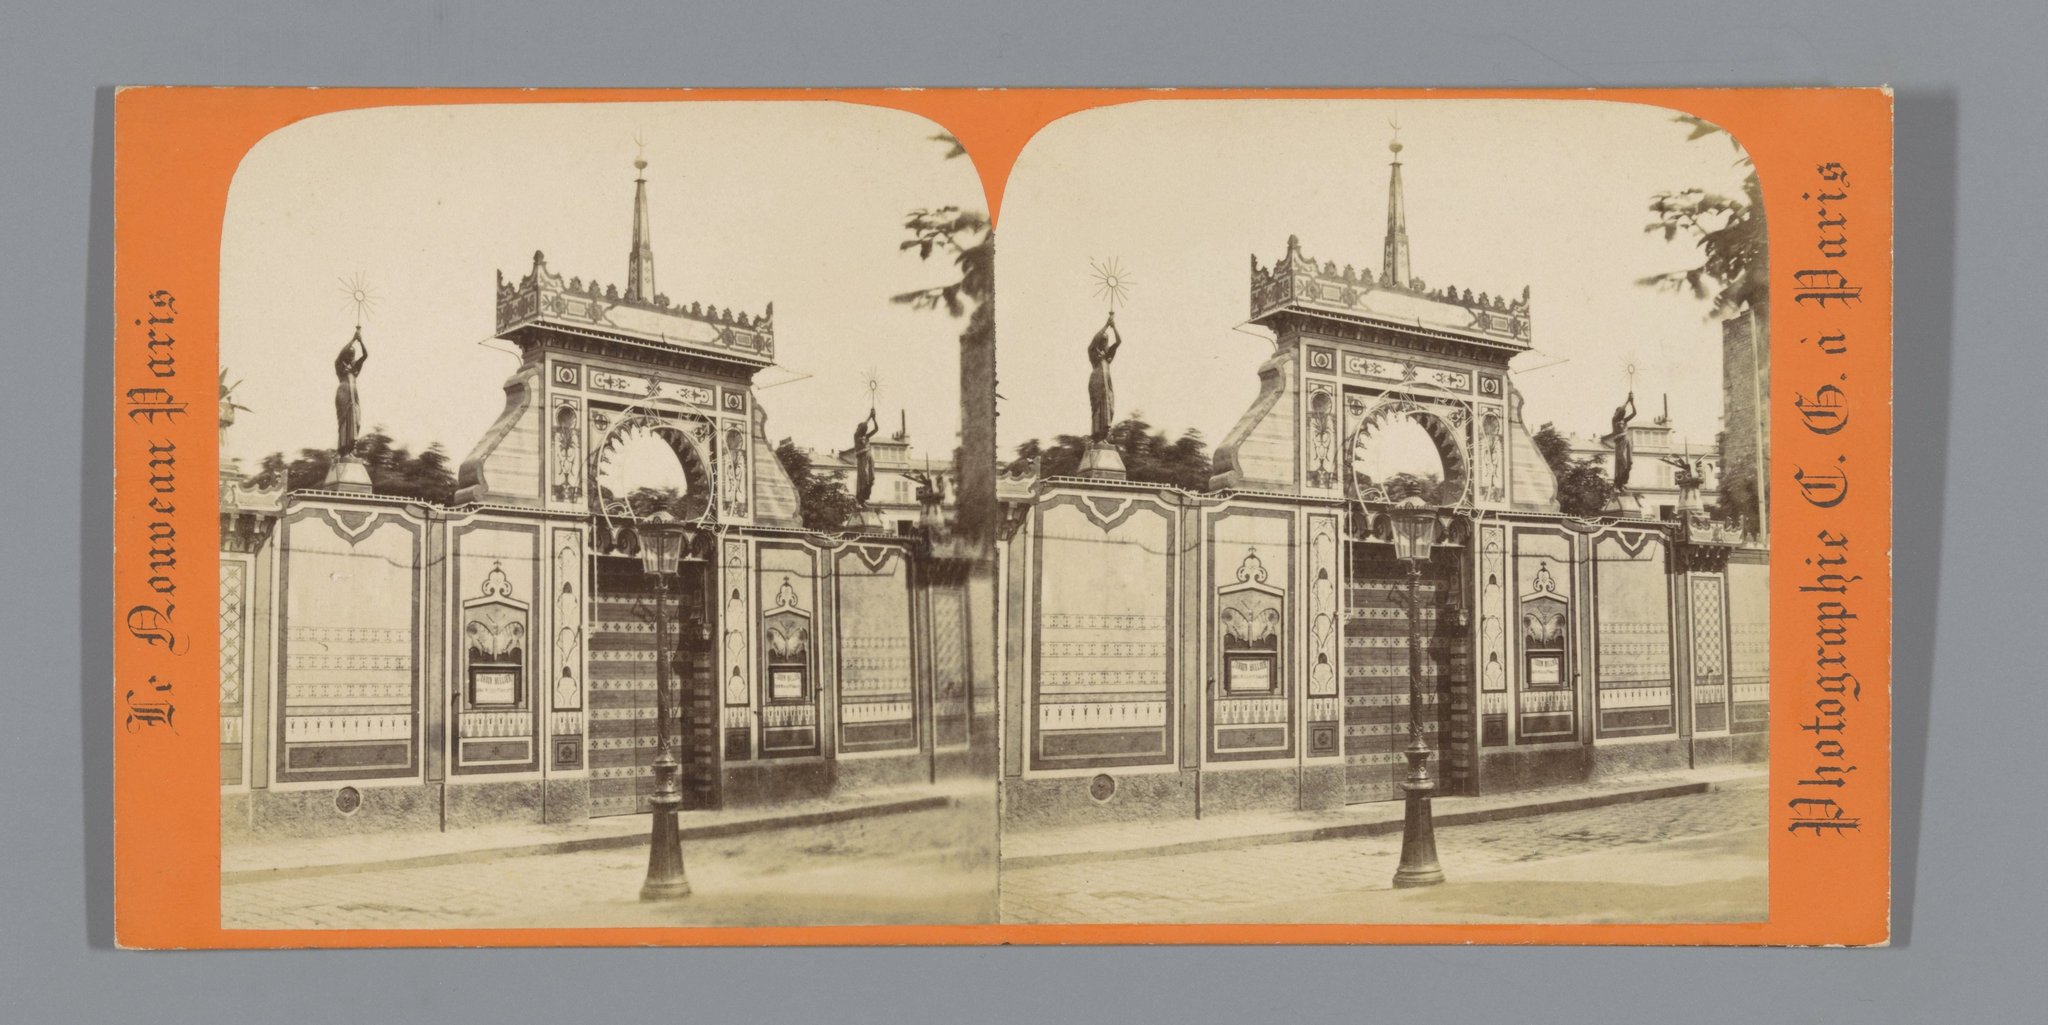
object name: stereograph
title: Le Nouveau Paris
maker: charles gérard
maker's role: fotograaf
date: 1850-1875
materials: cardboard, photographic support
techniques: albumen print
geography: paris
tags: gate, entrance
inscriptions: inscription: ‘Entrée du Bal Bullier’